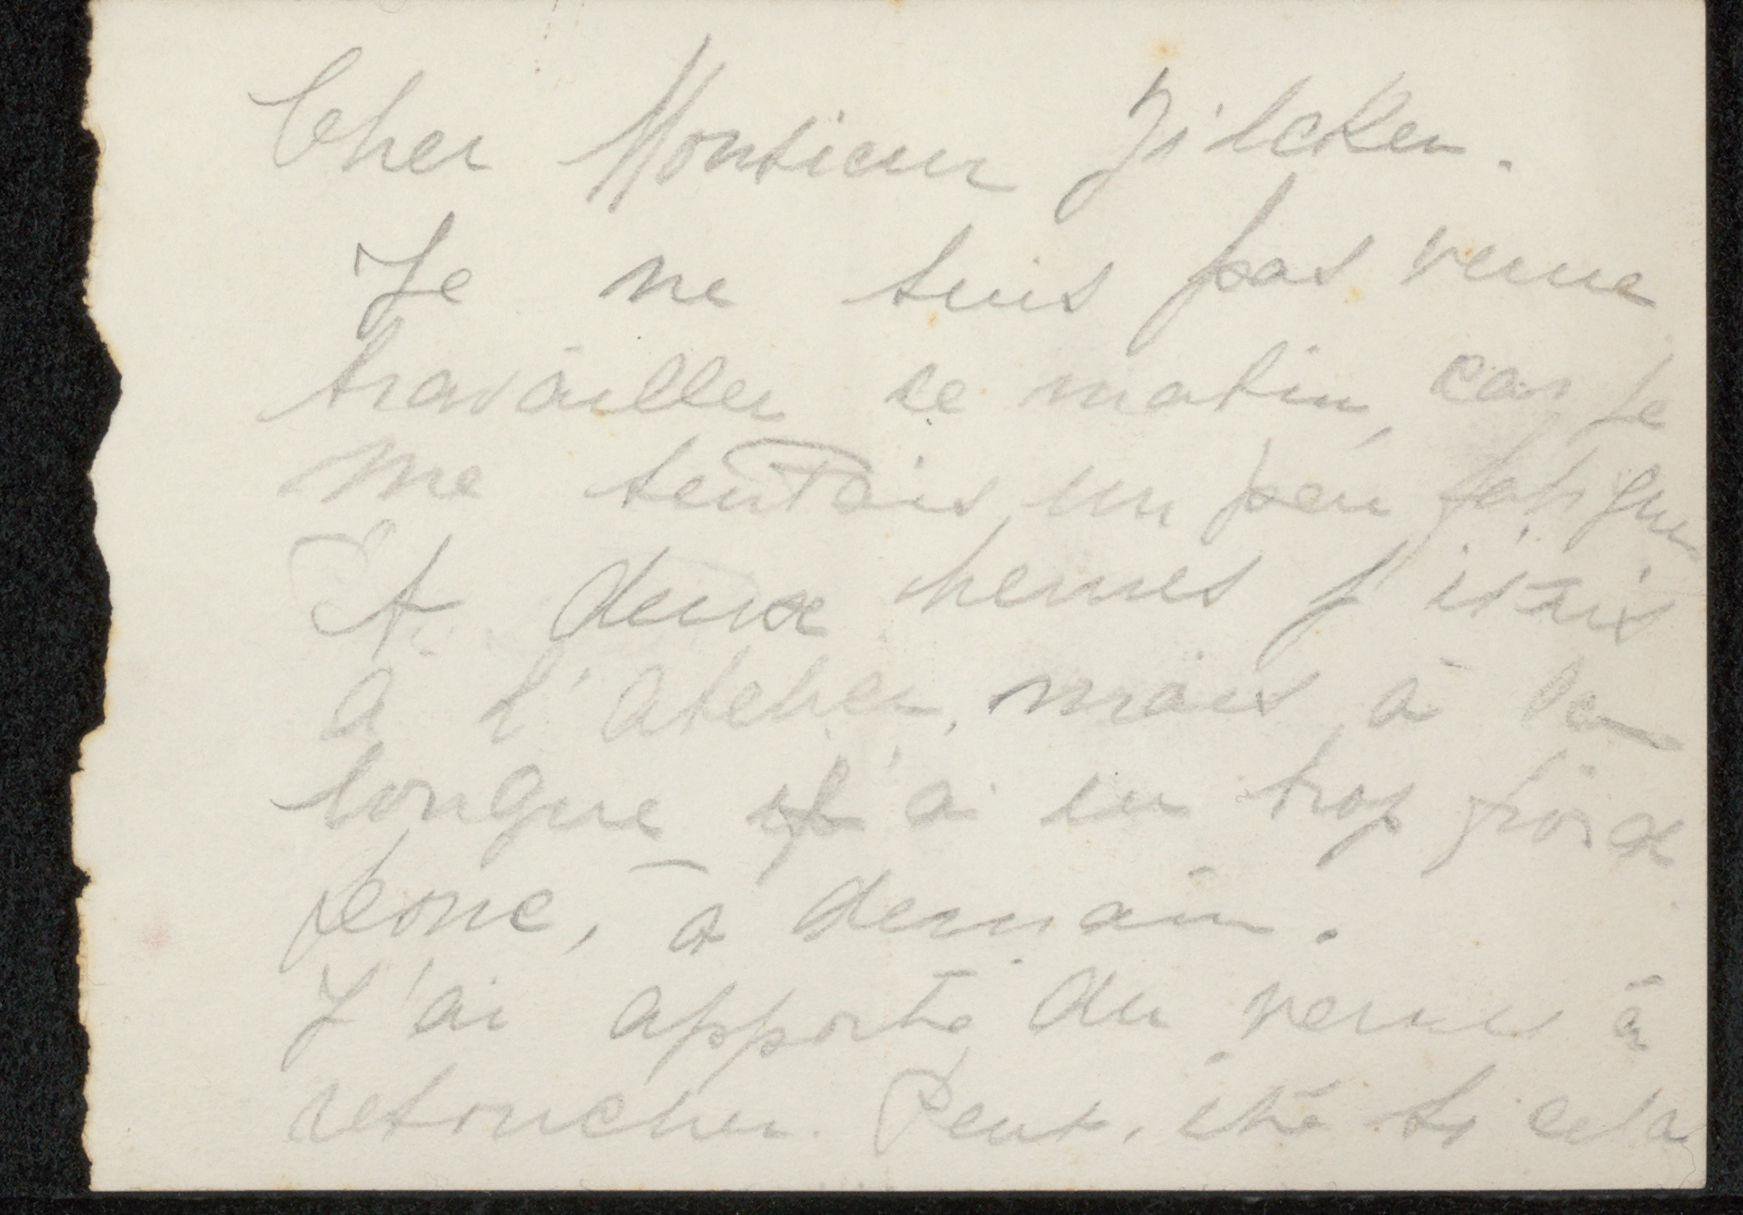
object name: letter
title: Brief aan Philip Zilcken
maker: rose imel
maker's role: draughtsman, painter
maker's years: 1901-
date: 1911-1930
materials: paper, pencil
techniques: writing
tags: painter, draughtsman, philip zilcken, workshop, studio of the artist (in general)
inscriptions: collector's mark: ‘RPK’